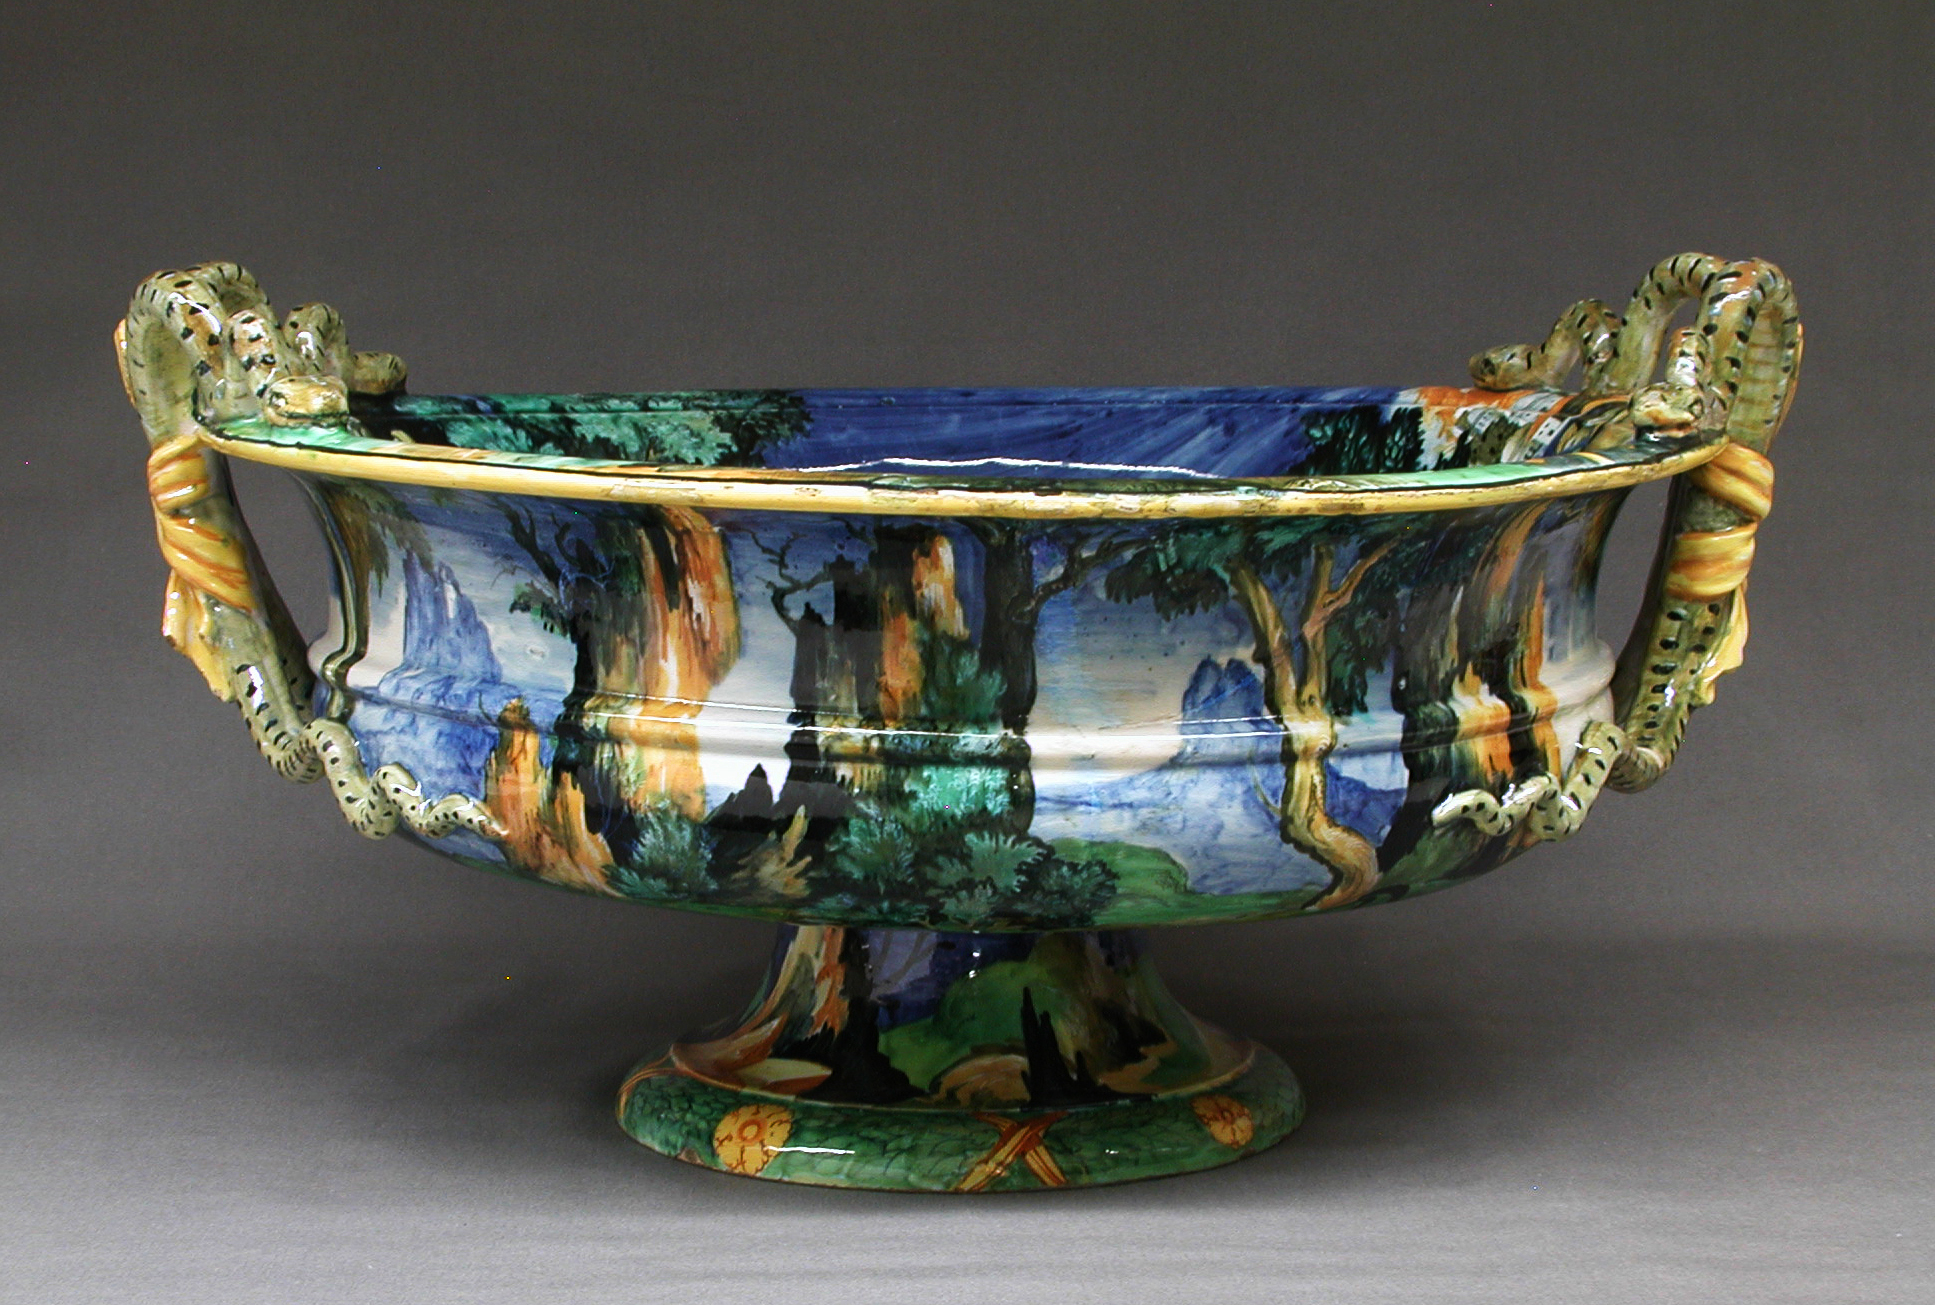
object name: cistern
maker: orazio fontana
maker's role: maker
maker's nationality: italian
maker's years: 1505-1576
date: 1545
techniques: maiolica, glazing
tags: male nudes,female nudes,horses,landscapes